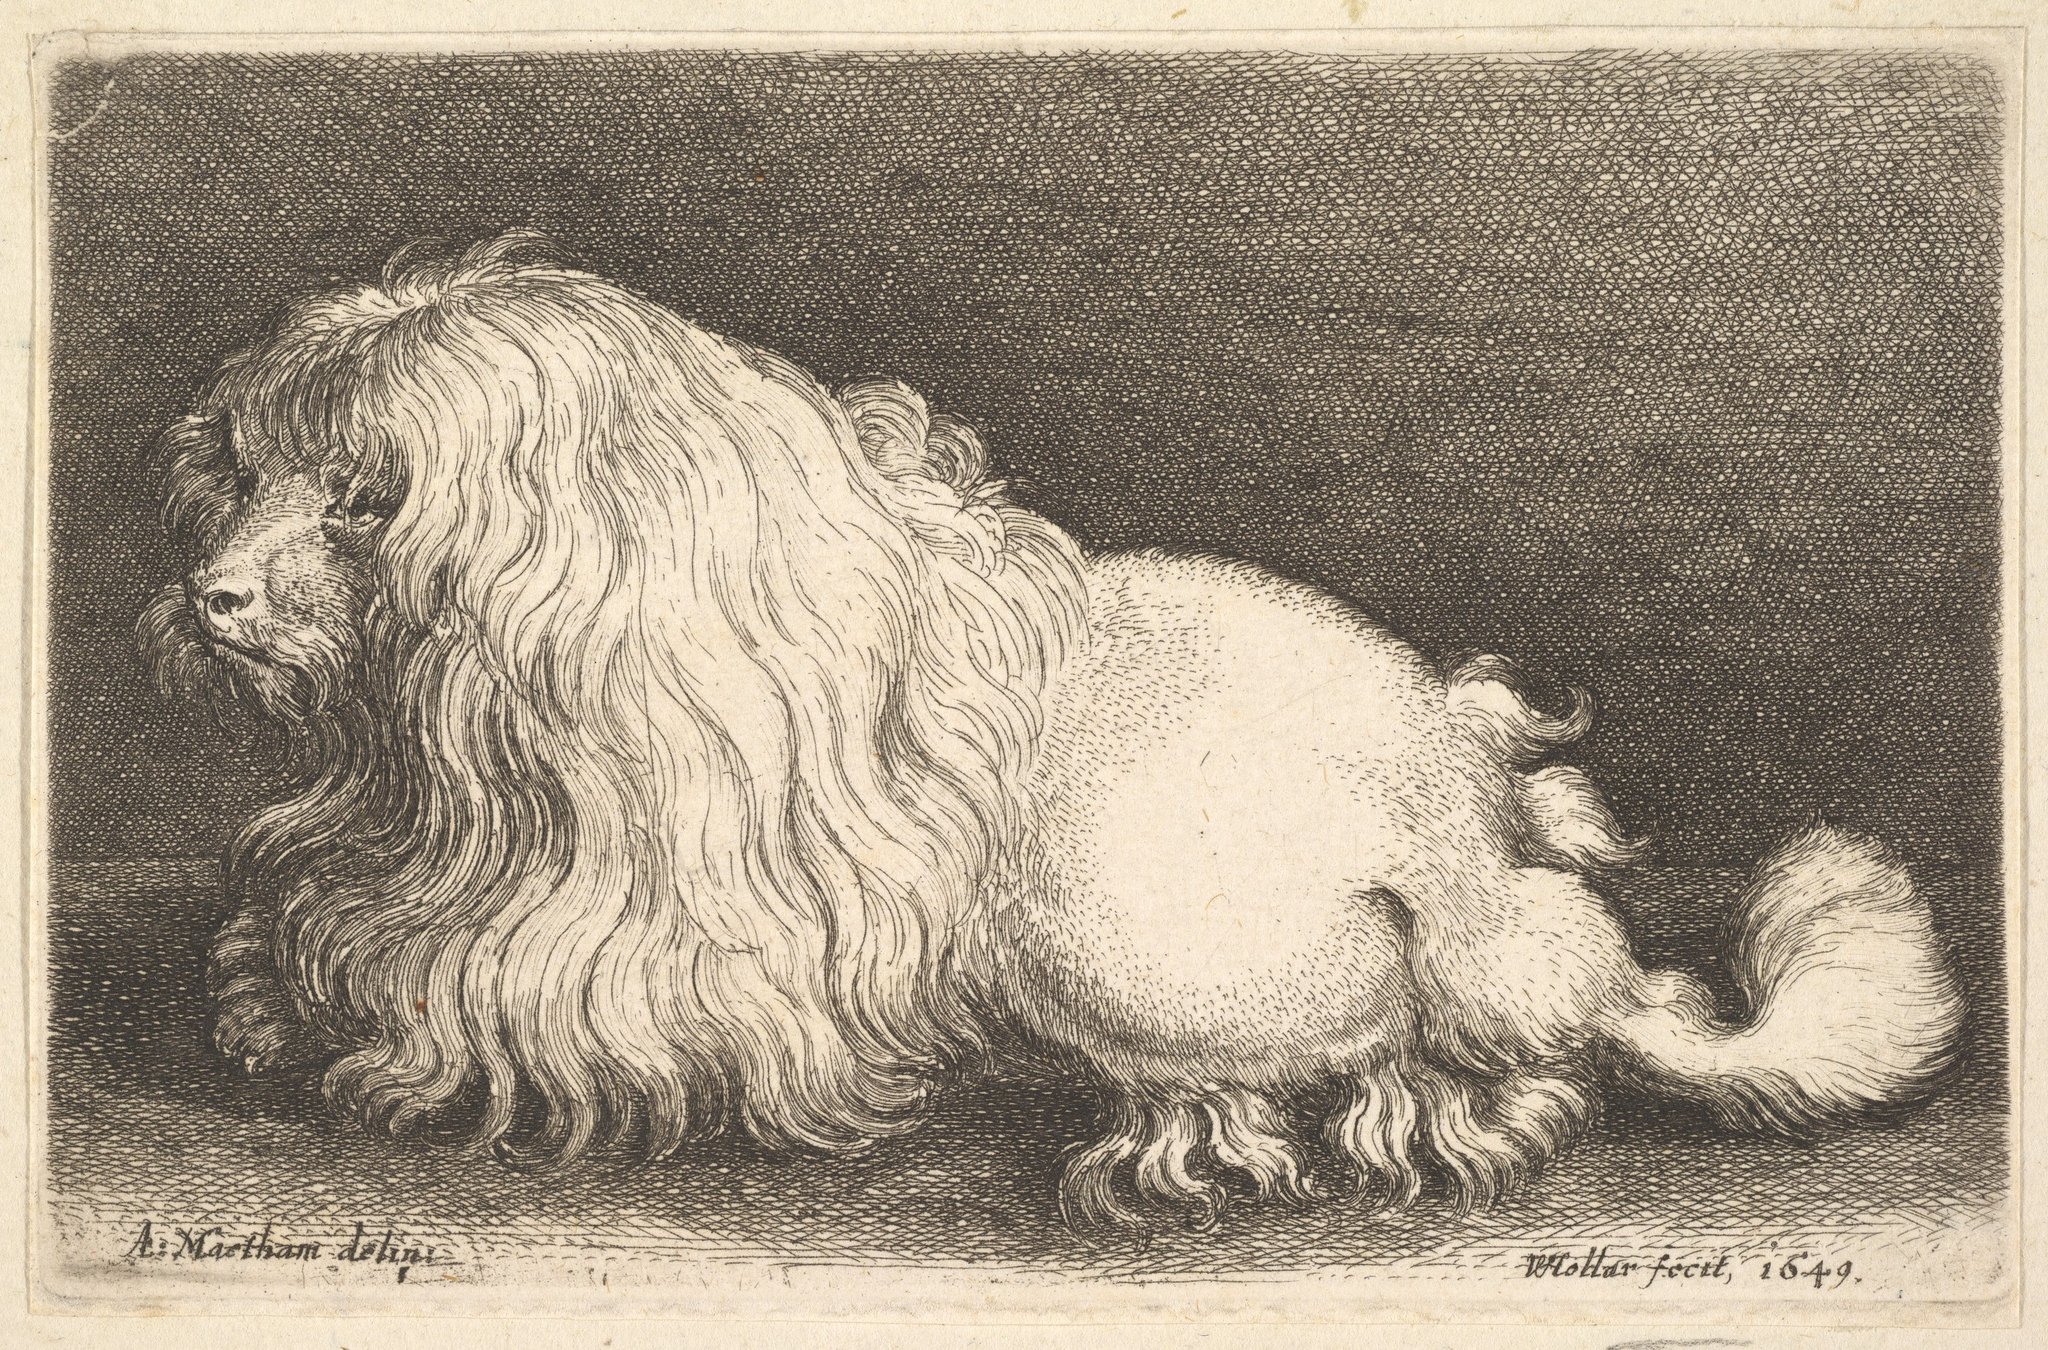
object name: print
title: White dog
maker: wenceslaus hollar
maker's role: artist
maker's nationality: bohemian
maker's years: 1607-1677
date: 1649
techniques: etching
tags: dogs